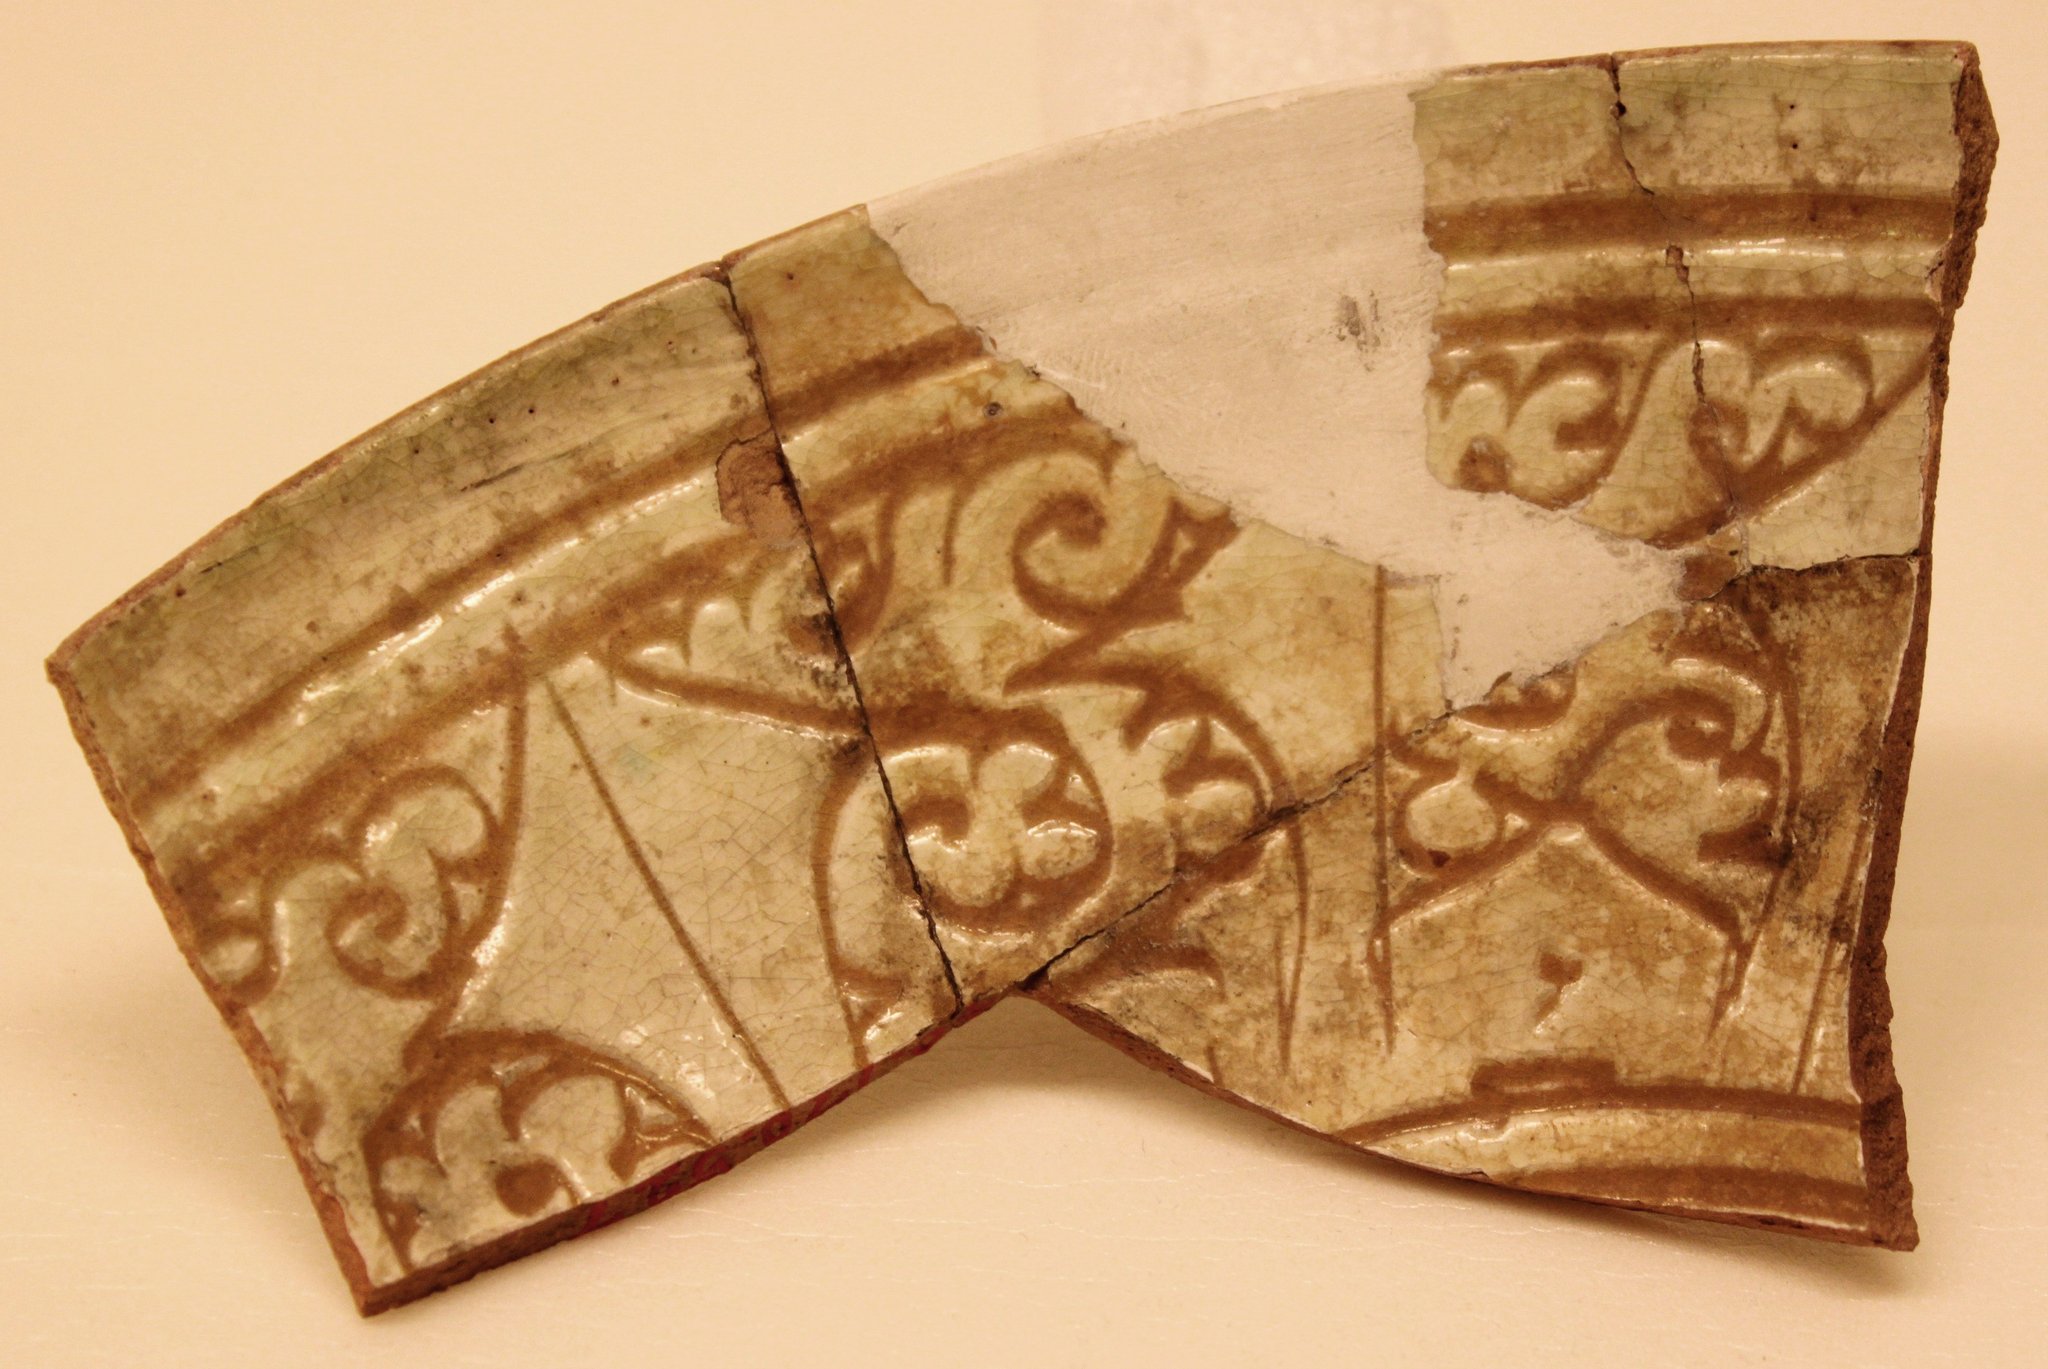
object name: fragment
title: Ceramic Fragment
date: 901-1100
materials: earthenware, glaze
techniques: incising, polychrome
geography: iran